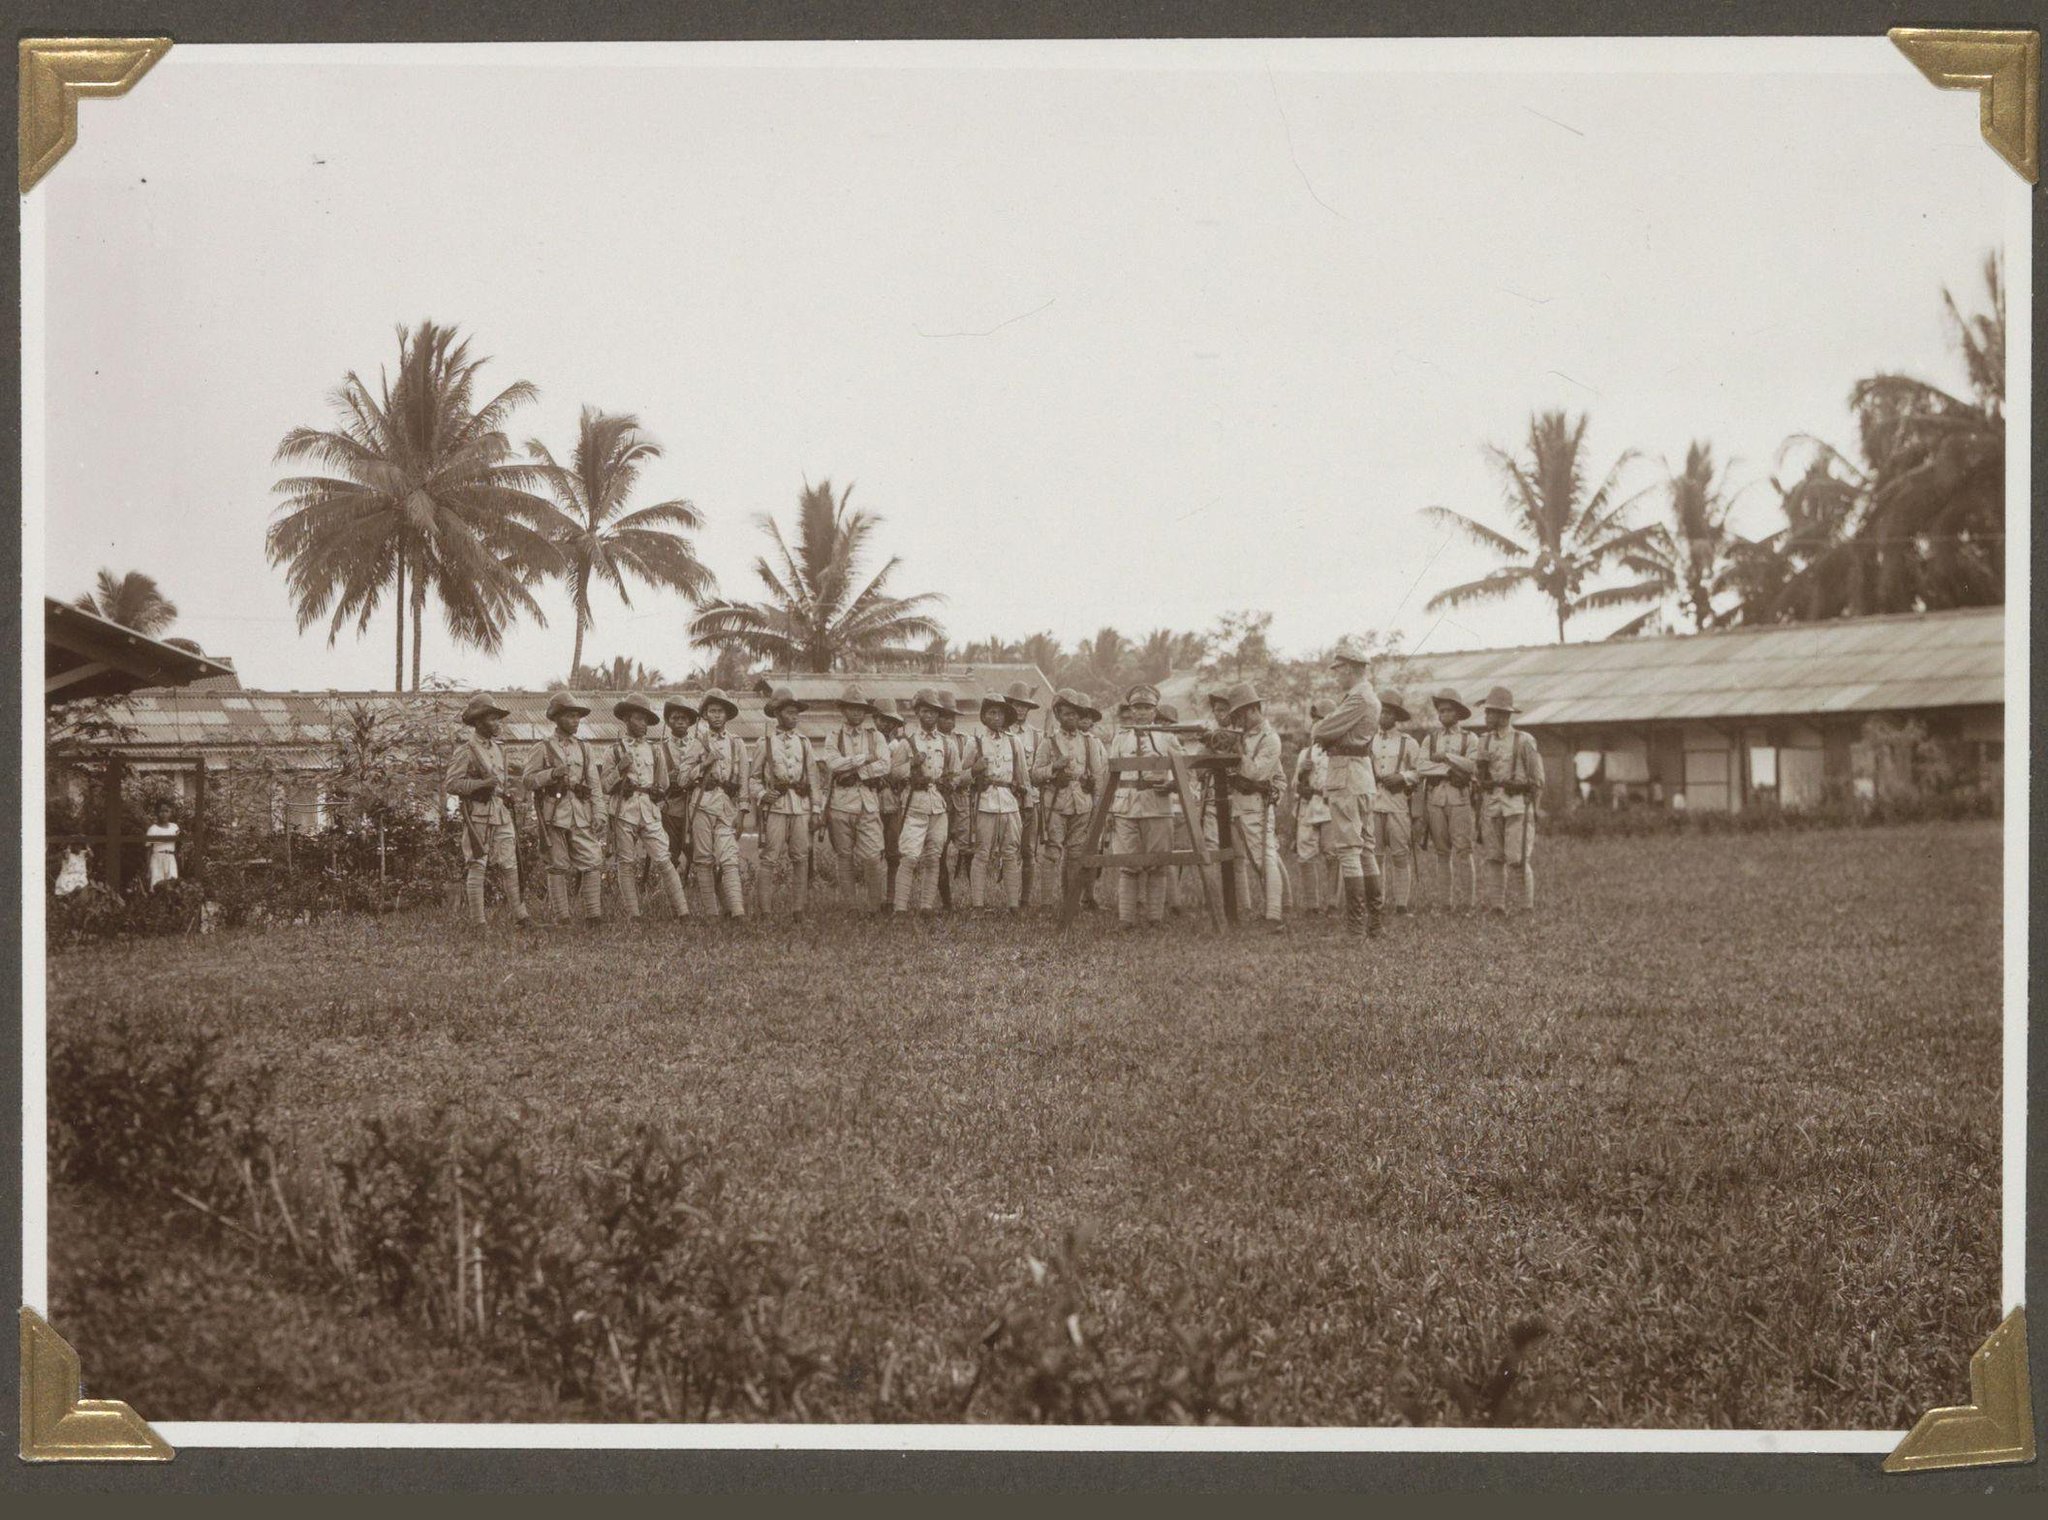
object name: photograph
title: Schiet-onderricht met den richtbok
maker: Anonymous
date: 1932-1933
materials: photographic support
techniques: gelatin silver print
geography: lampung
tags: firearms, police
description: Onderdeel van Herinneringsalbum voor F.J. Junius, vertrekkend resident van Lampong (Zuid-Sumatra).